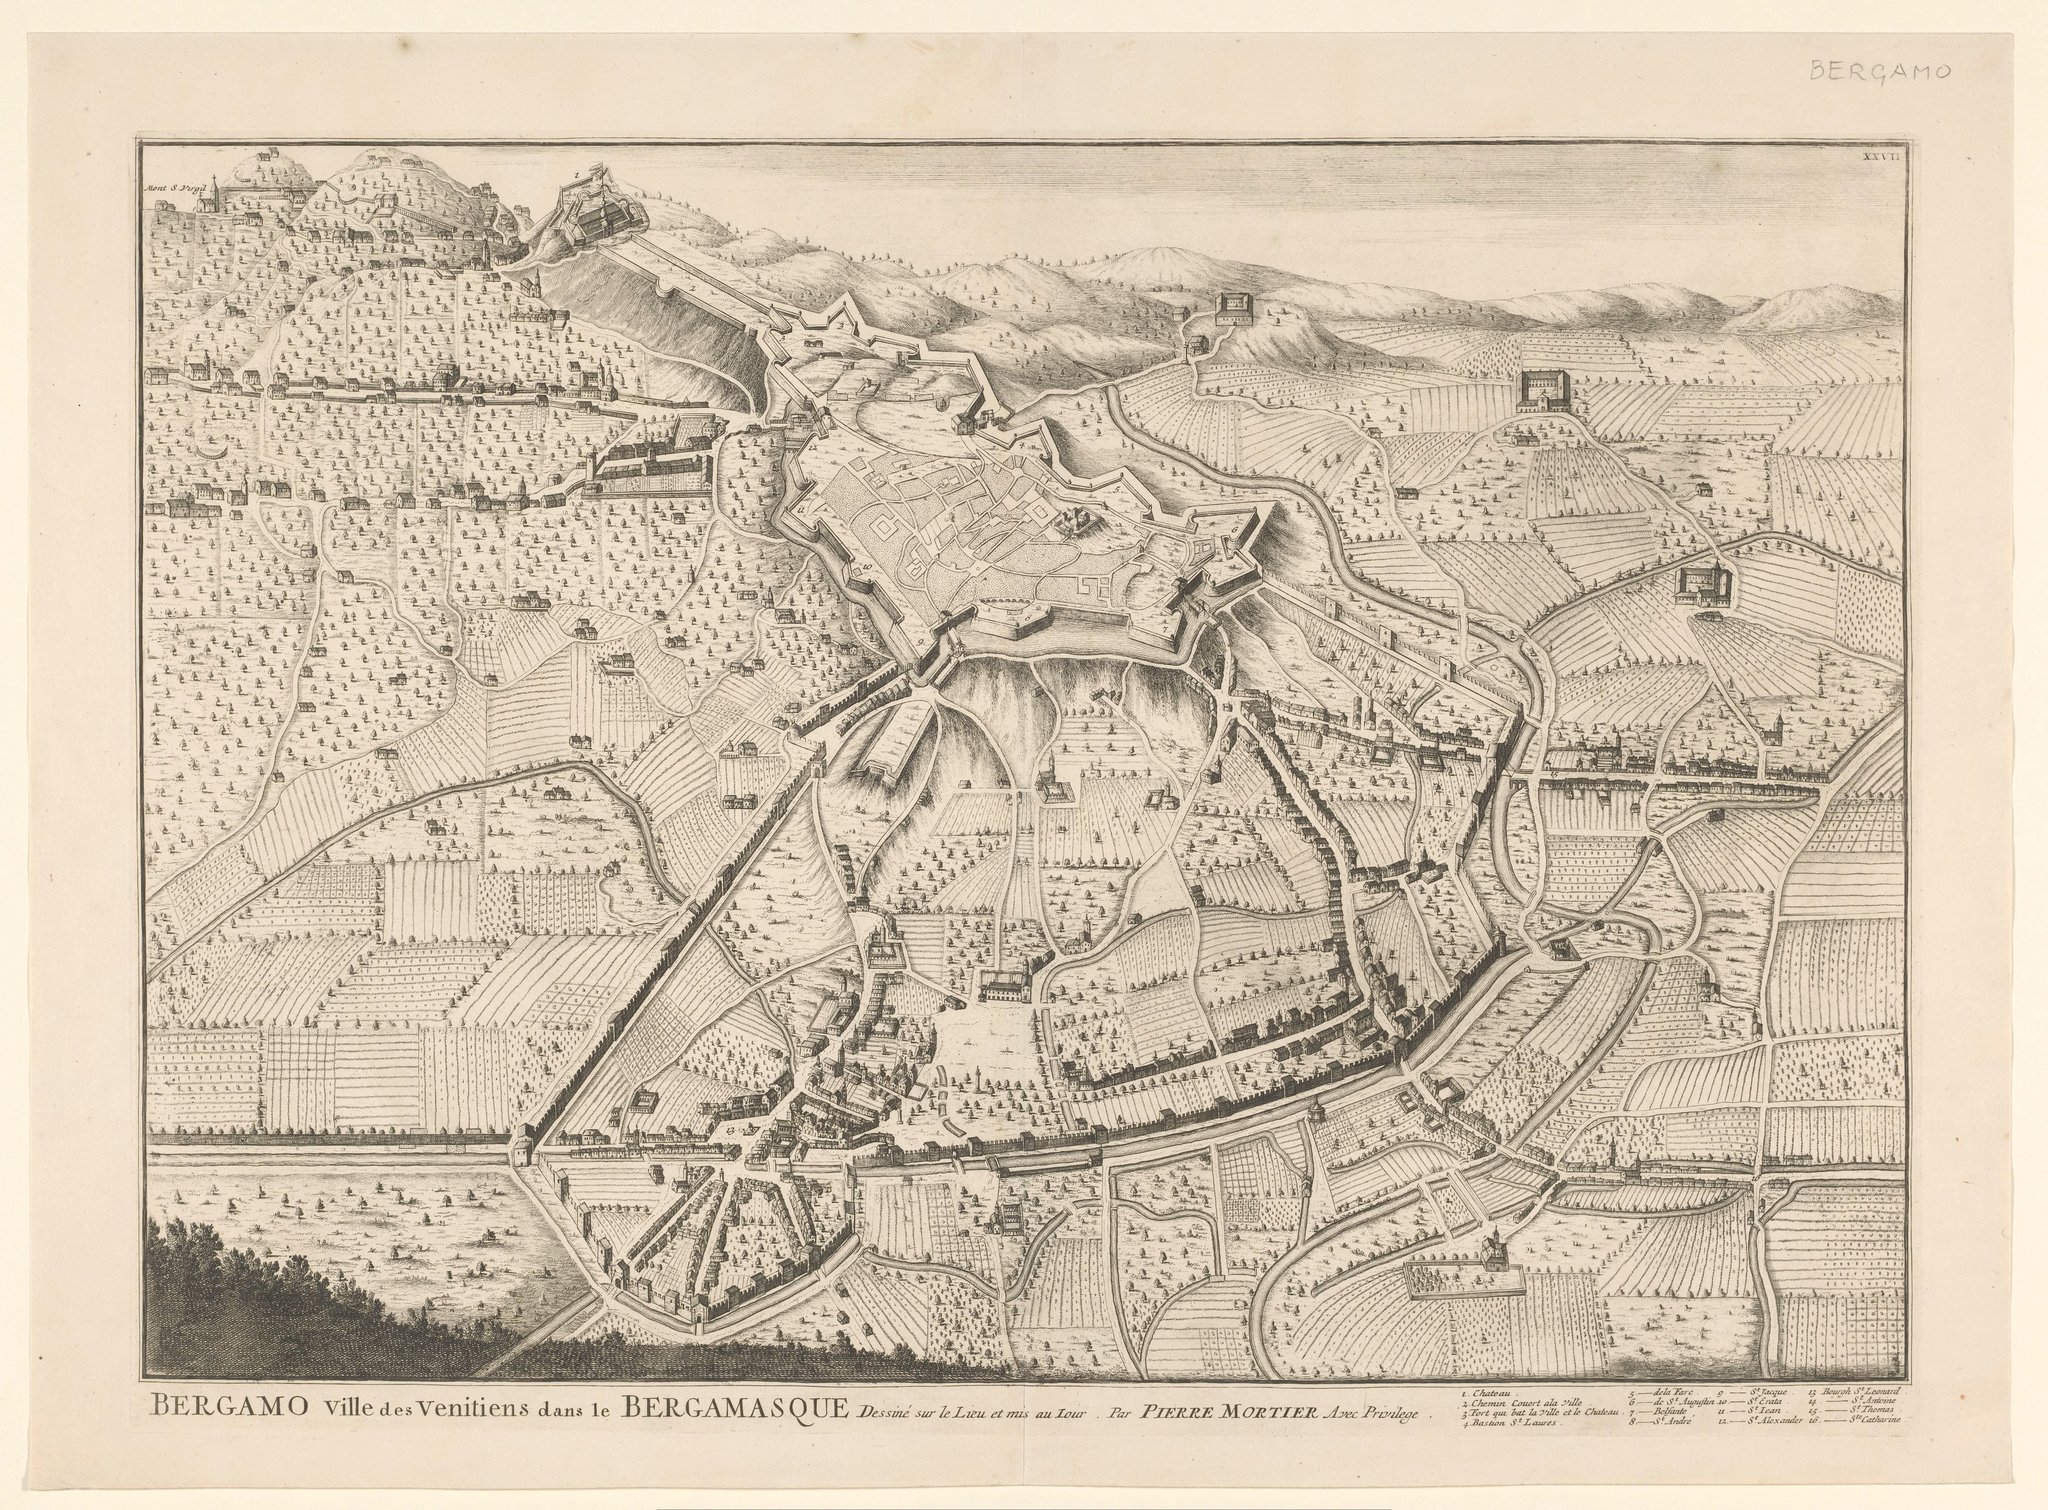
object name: area plan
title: Plattegrond van Bergamo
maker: Anonymous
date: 1704-1724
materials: paper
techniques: engraving, etching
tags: maps of cities, prospect of city, town panorama, silhouette of city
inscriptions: collector's mark: Lugt 2228